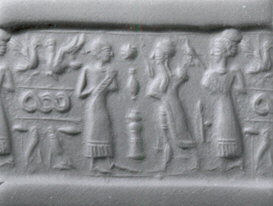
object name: cylinder seal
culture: syrian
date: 1800-1601 BCE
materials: mineral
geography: syria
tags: birds